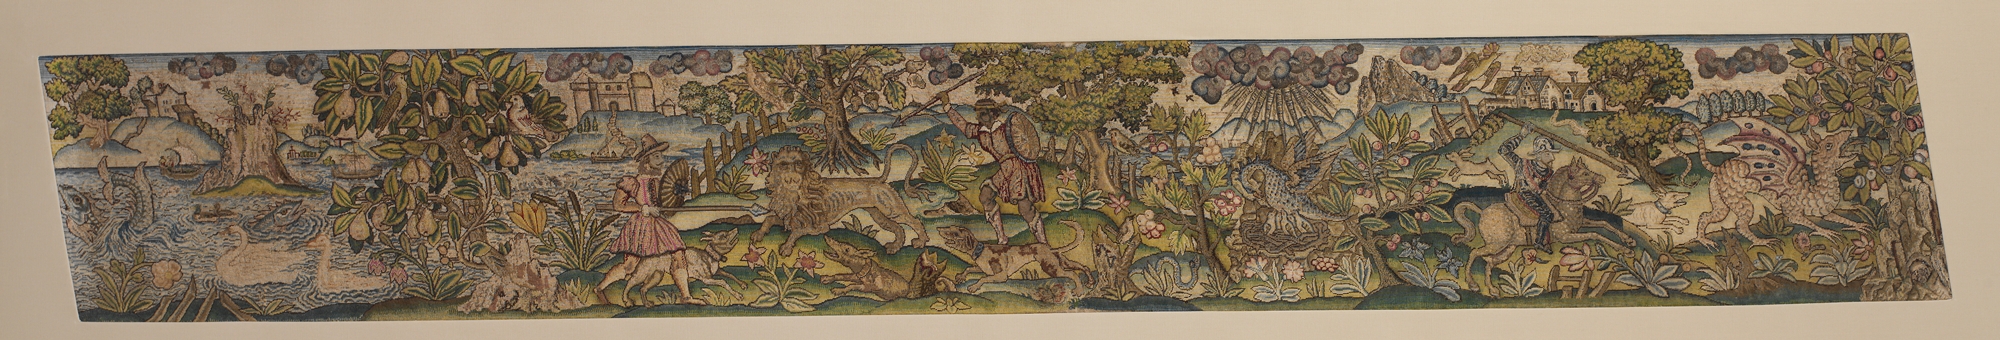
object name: valance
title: Valance (one of a set of three)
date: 1600-1633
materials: canvas, metal thread, silk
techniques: embroidery, stitching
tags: men,hunting,dragons,swans,dogs,fish,horses,lions